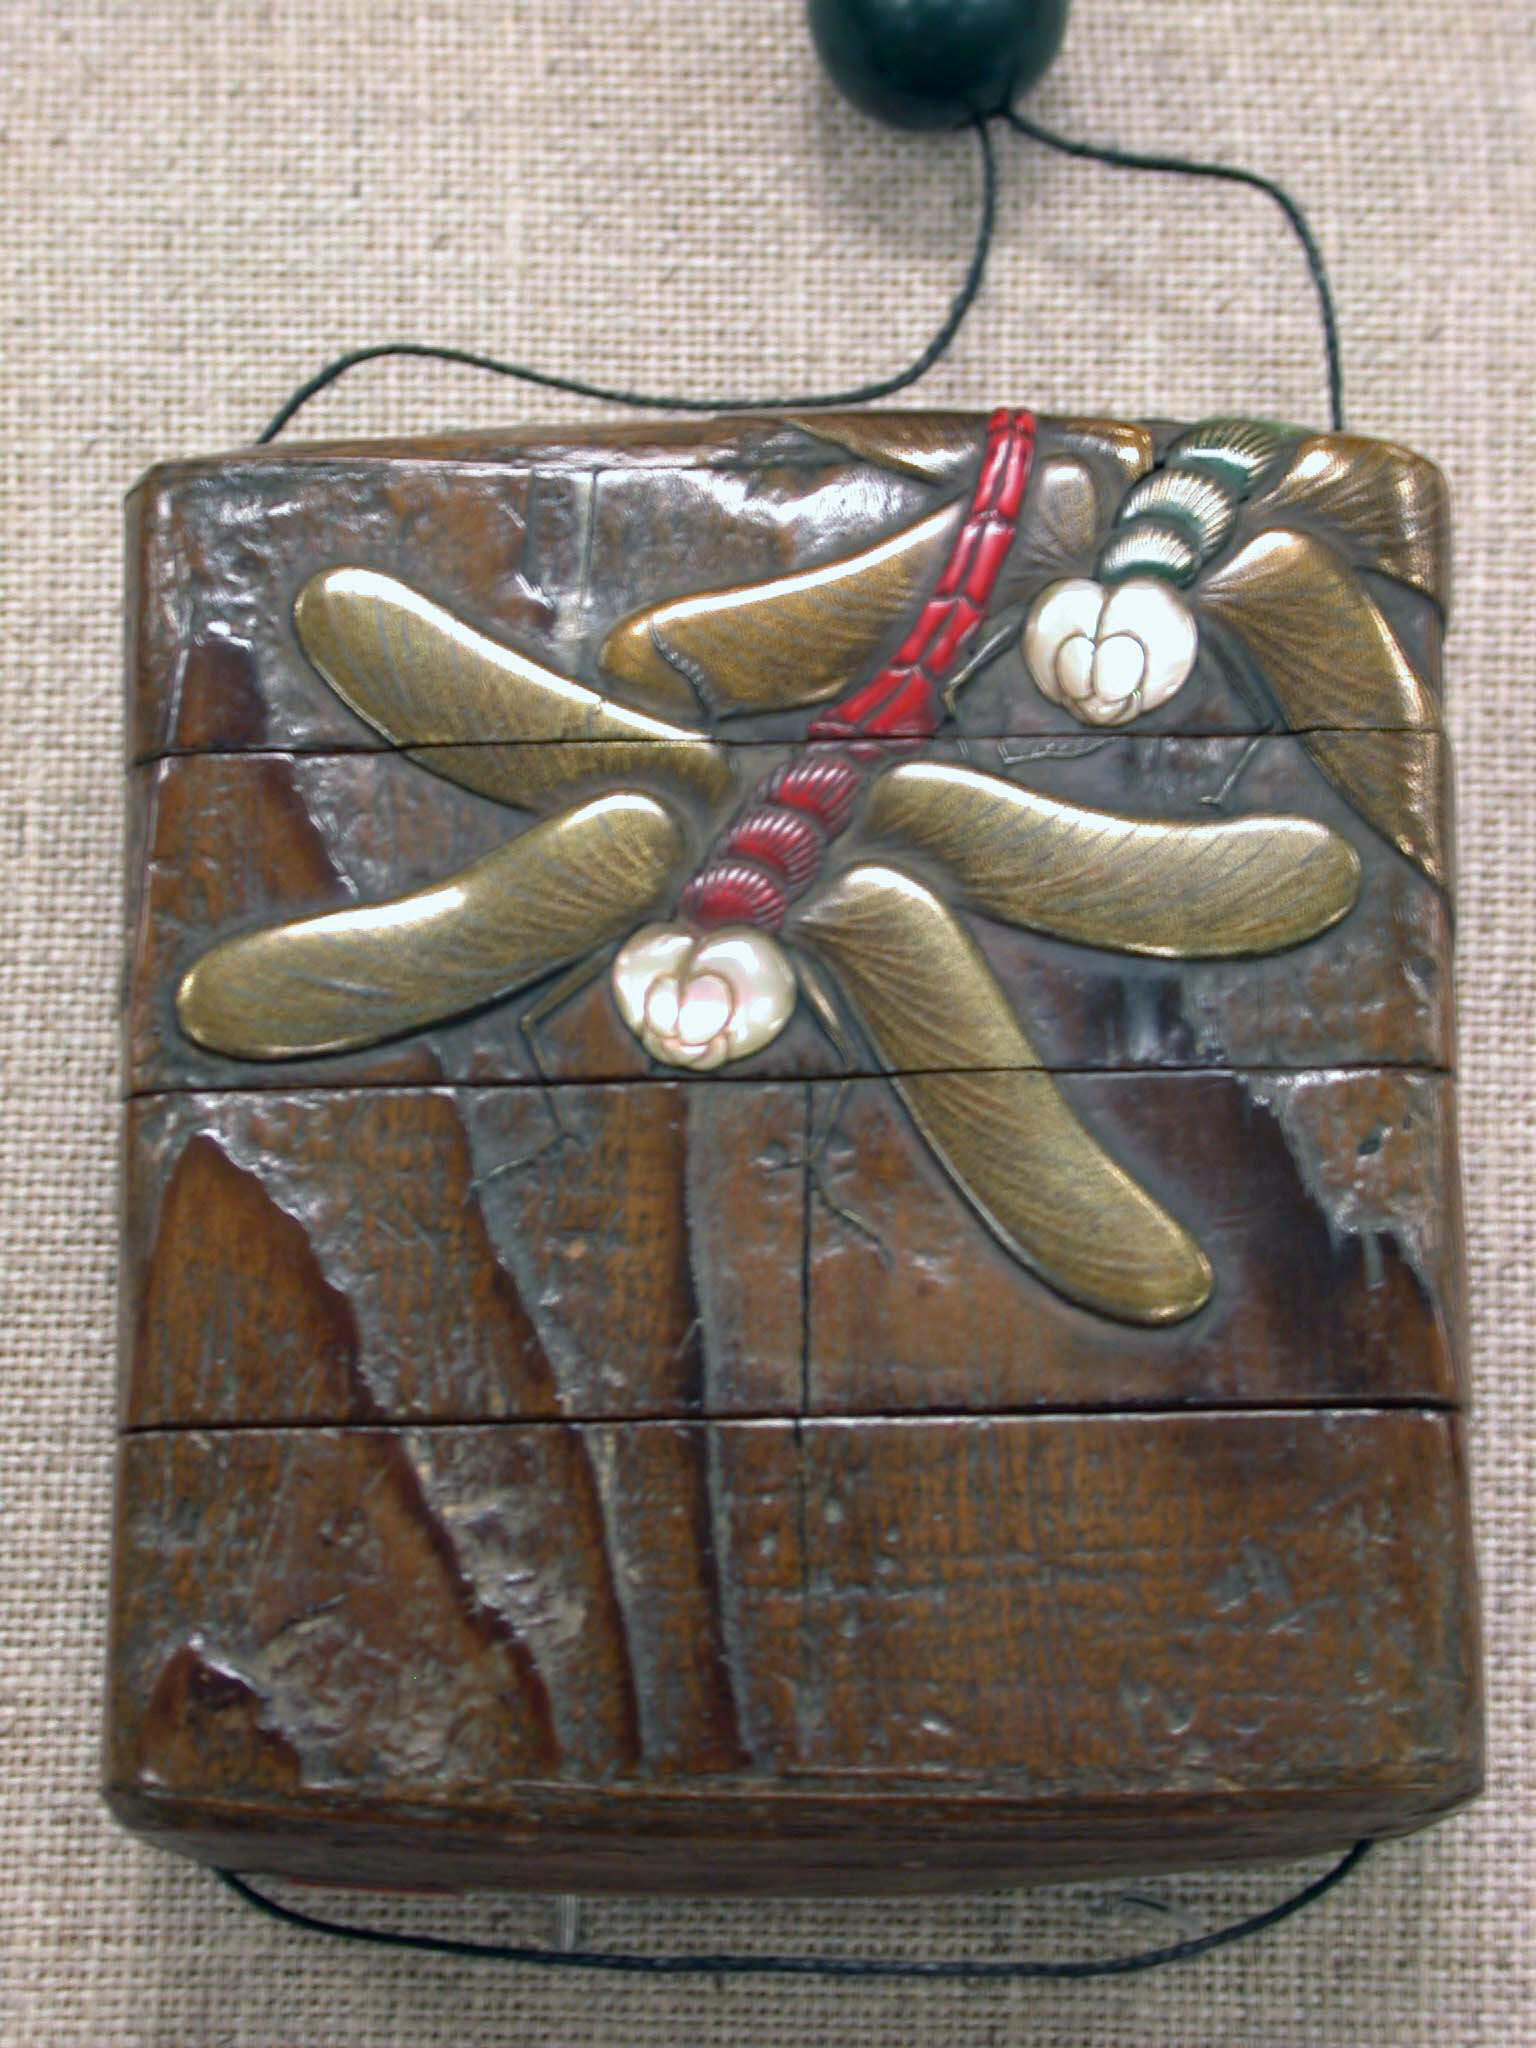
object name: inrō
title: Case (Inrō) with Design of Dragonflies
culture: japanese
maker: mochizuki hanzan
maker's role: artist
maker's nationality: japanese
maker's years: 1743-1790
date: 1701-1900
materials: gold, wood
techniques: fundame, hiramakie, maki-e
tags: dragonflies